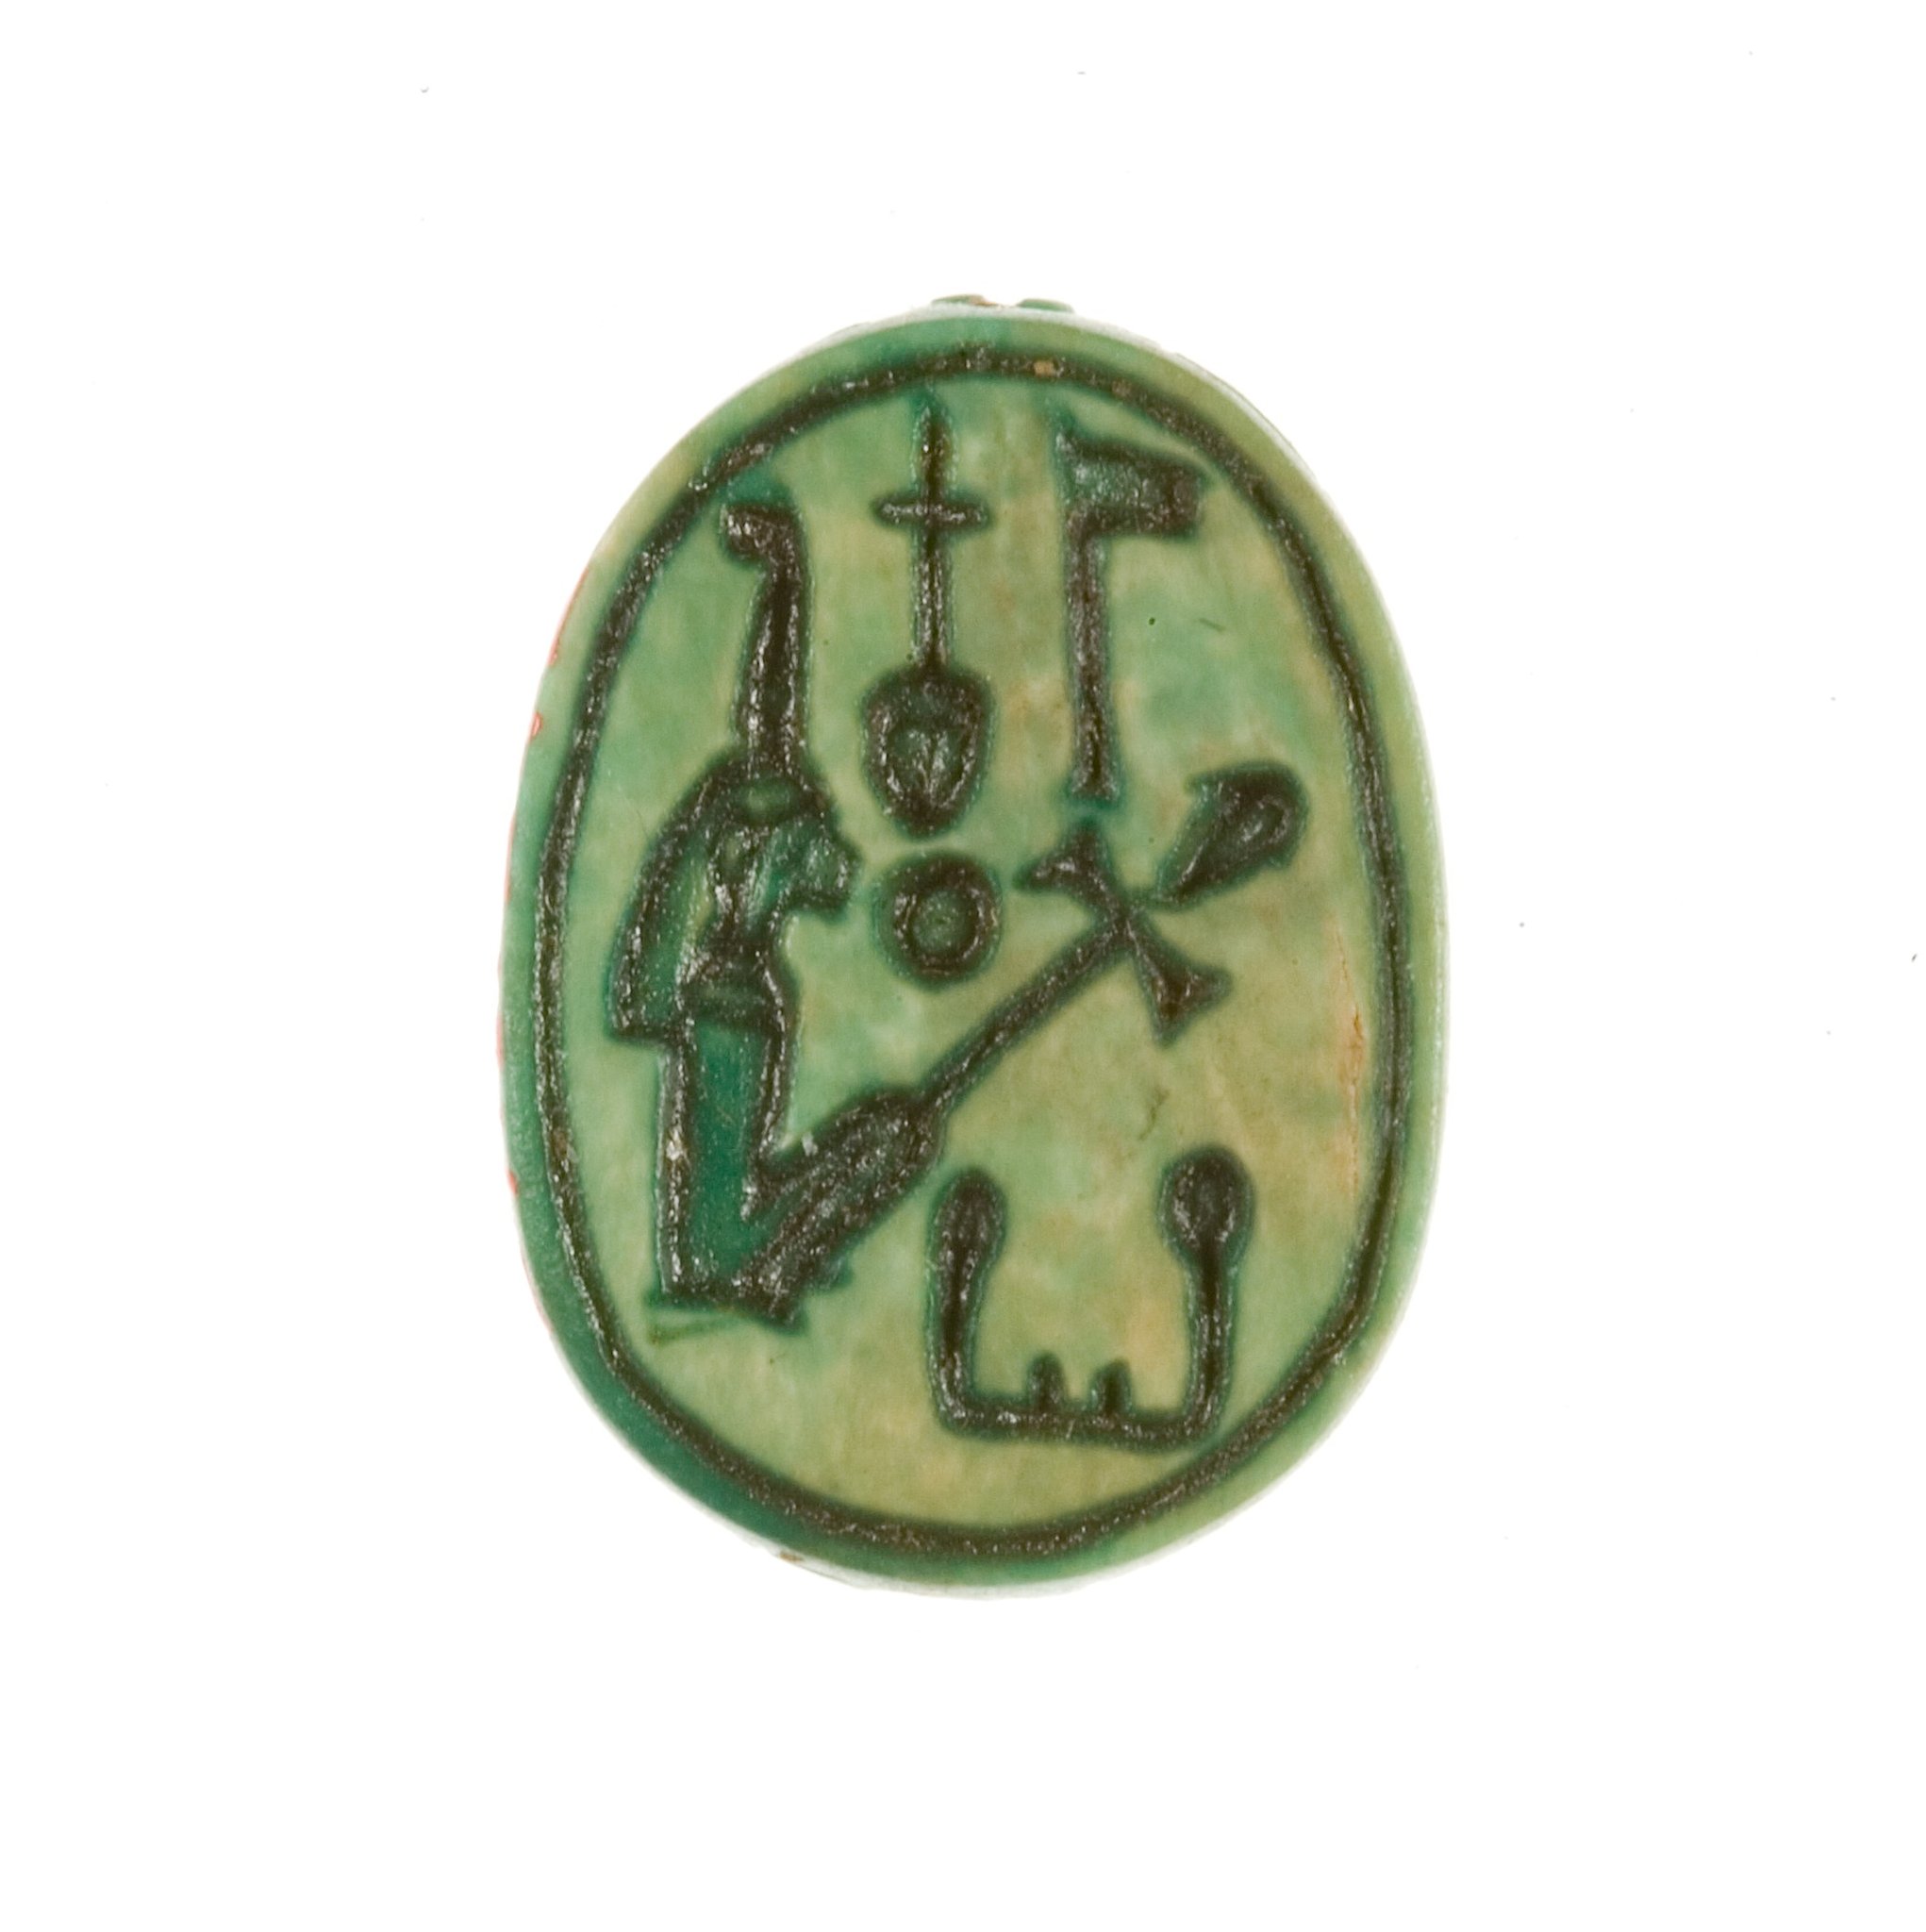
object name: scarab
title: Scarab Inscribed for the Perfect God Maatkare (Hatshepsut)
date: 1479-1458 BCE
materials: stone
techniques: glazing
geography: egypt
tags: hieroglyphs,scarabs